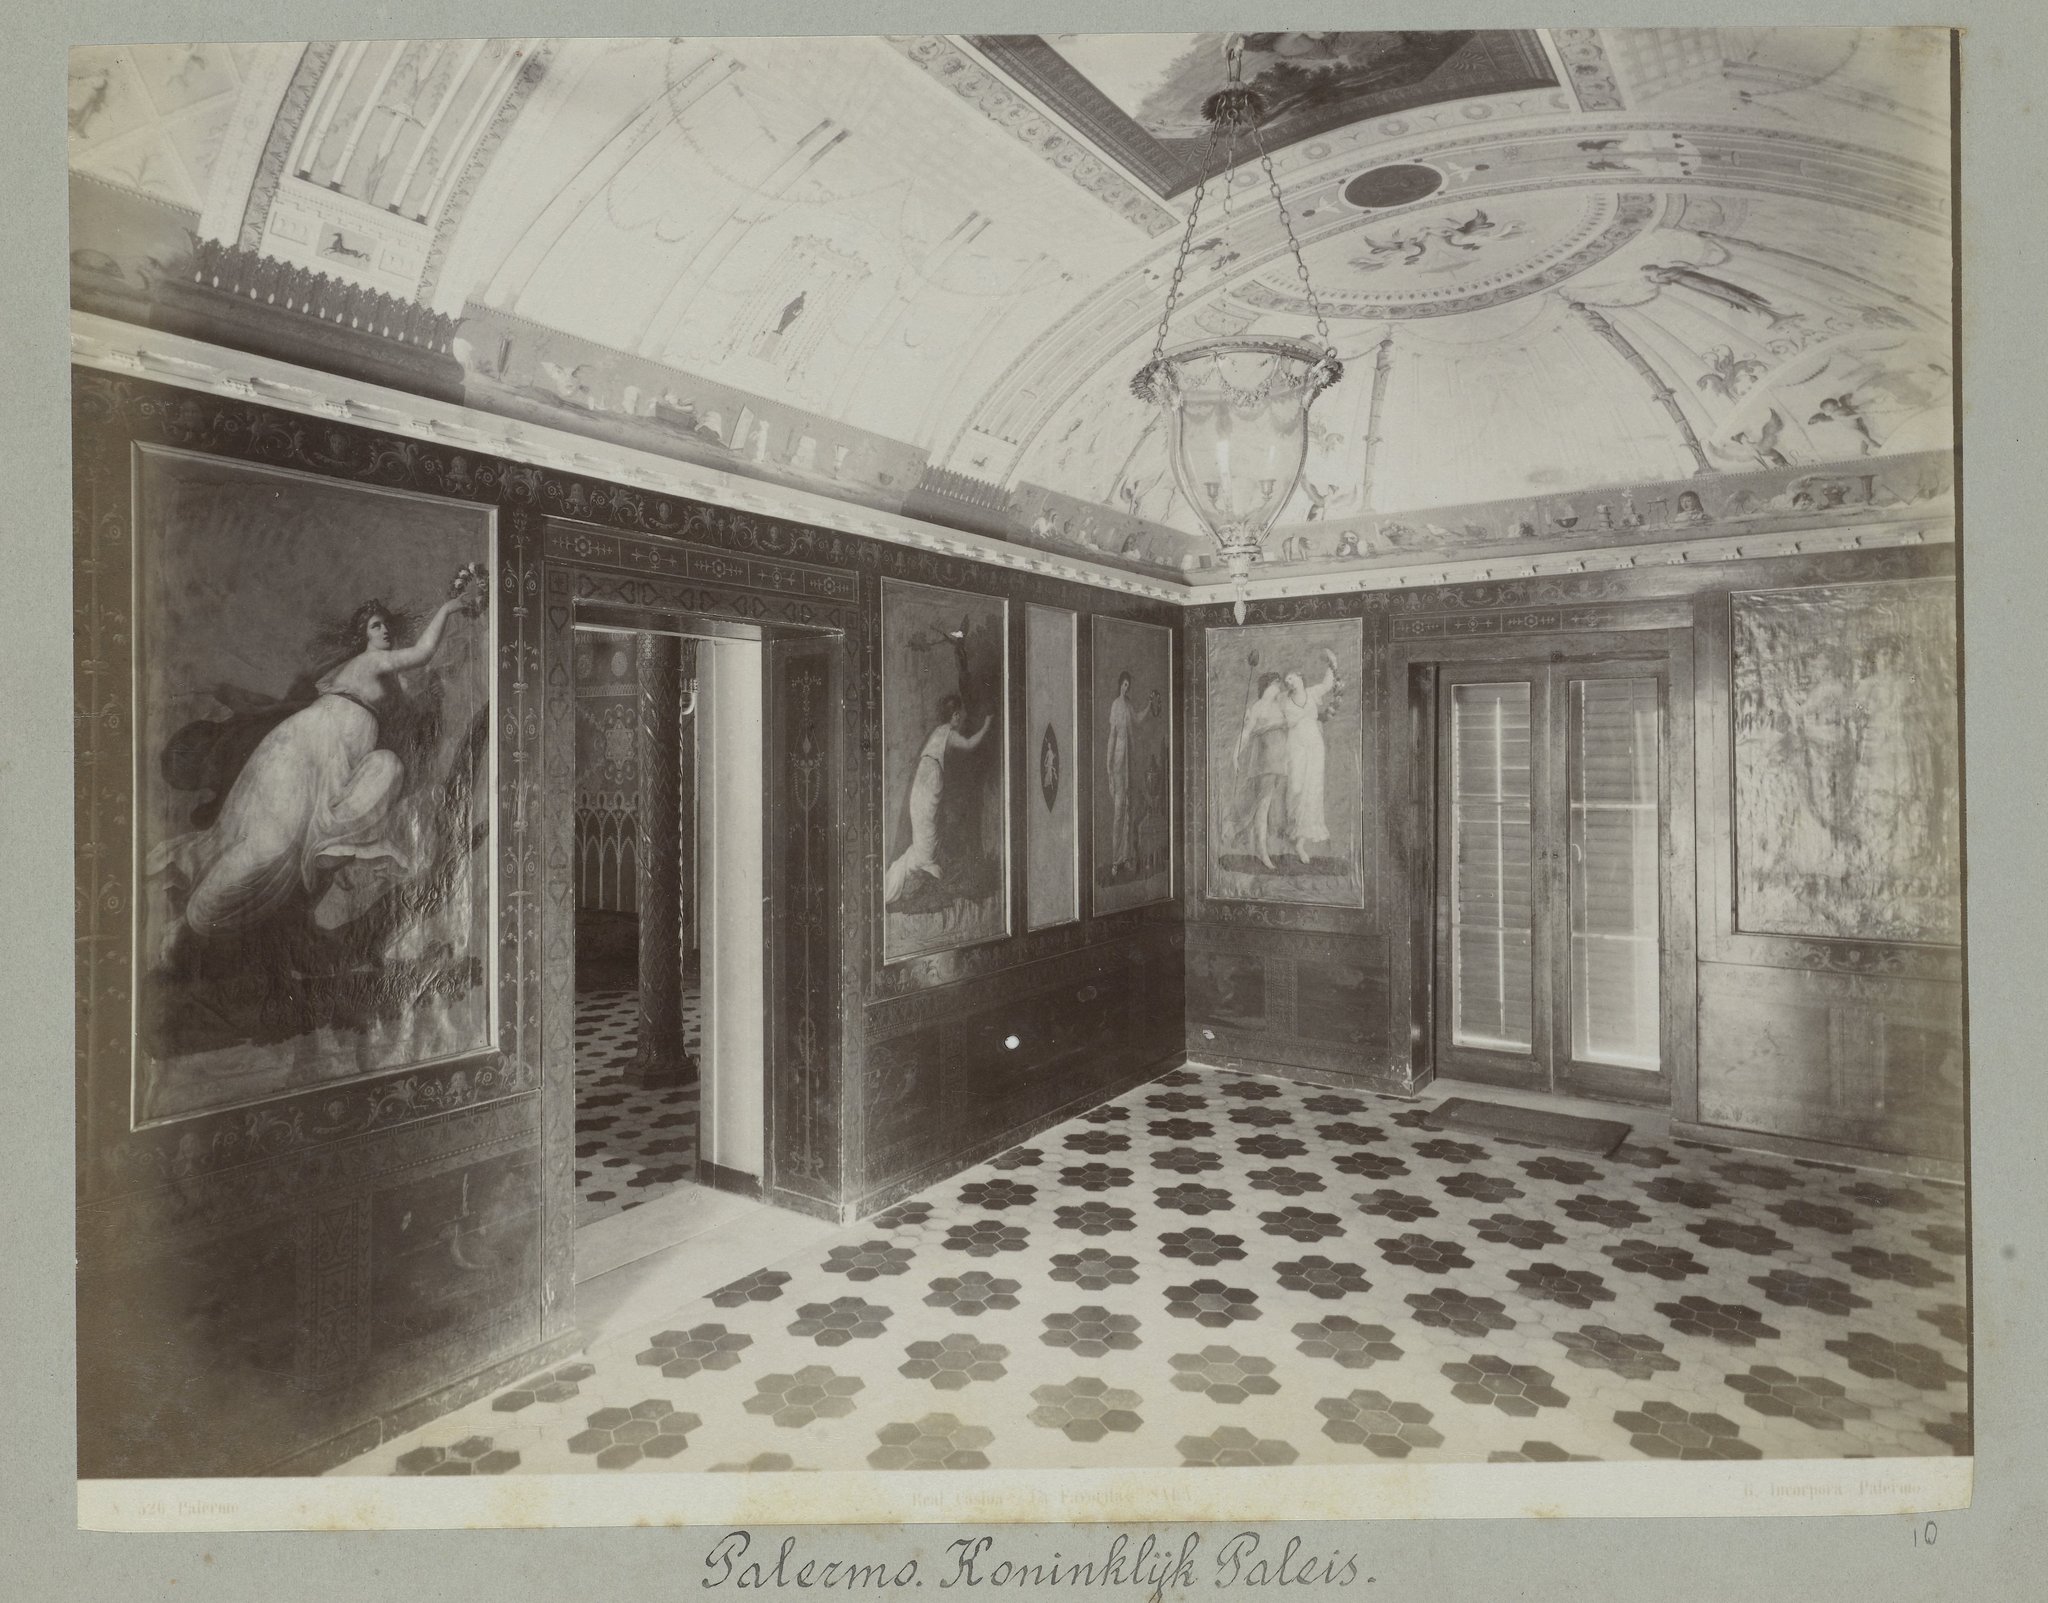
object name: photograph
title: N. 526 palermo (...)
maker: giuseppe incorpora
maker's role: fotograaf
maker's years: 1834-1914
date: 1893-1903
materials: cardboard, photographic support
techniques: albumen print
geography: netherlands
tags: palermo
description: Interieur van het koninklijk paleis in Palermo